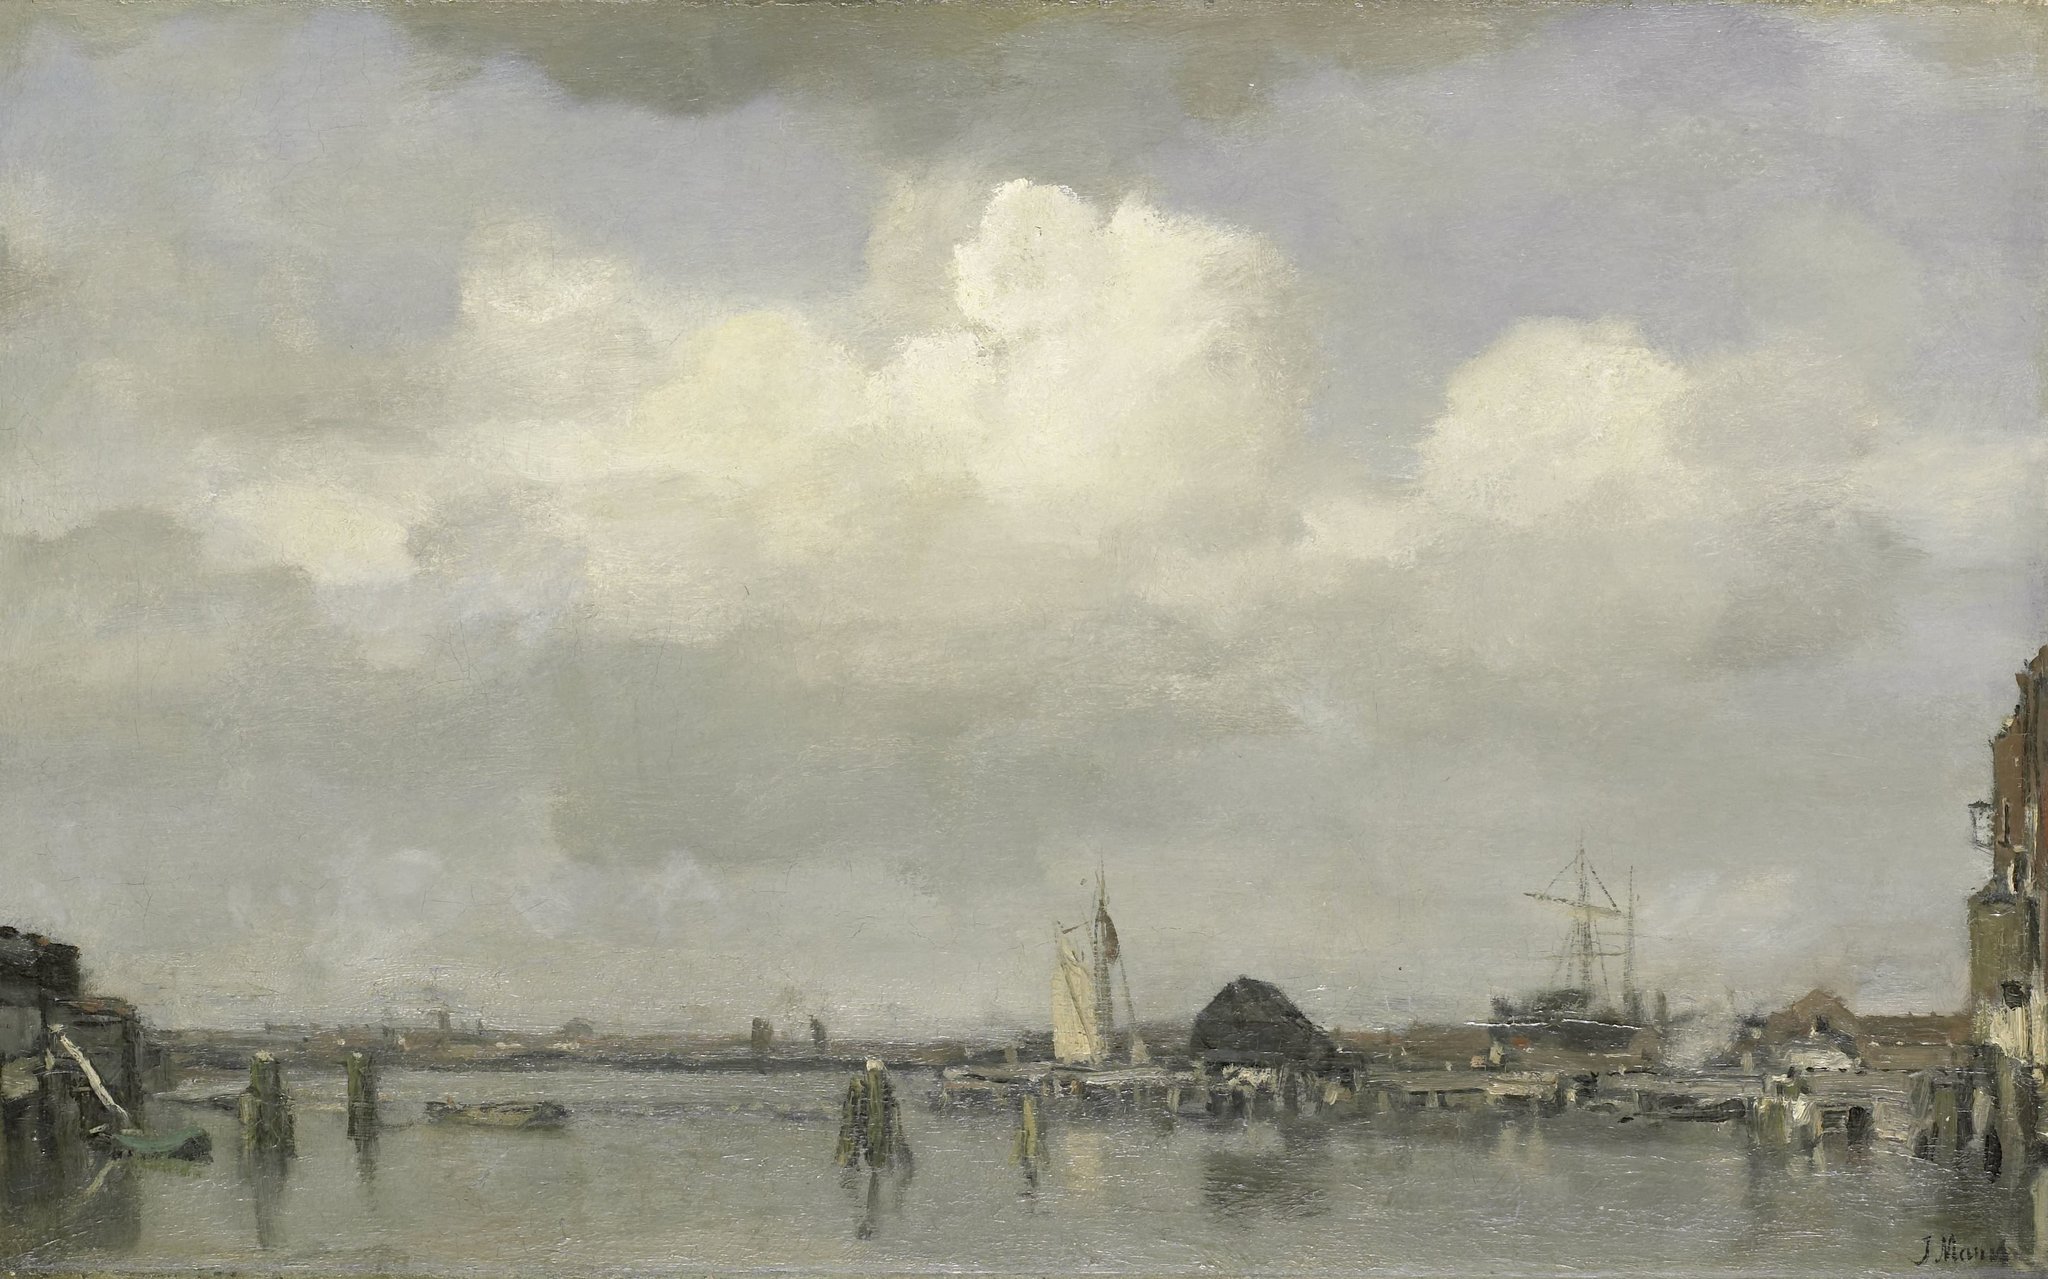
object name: painting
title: Havengezicht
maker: jacob maris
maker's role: draughtsman, painter, print maker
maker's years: 1837-1899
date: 1890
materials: canvas, oil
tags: harbour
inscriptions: signature: ‘J Maris’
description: Havengezicht. Gezicht over een watervlakte met rechts steigers en in de verte een groot schip.